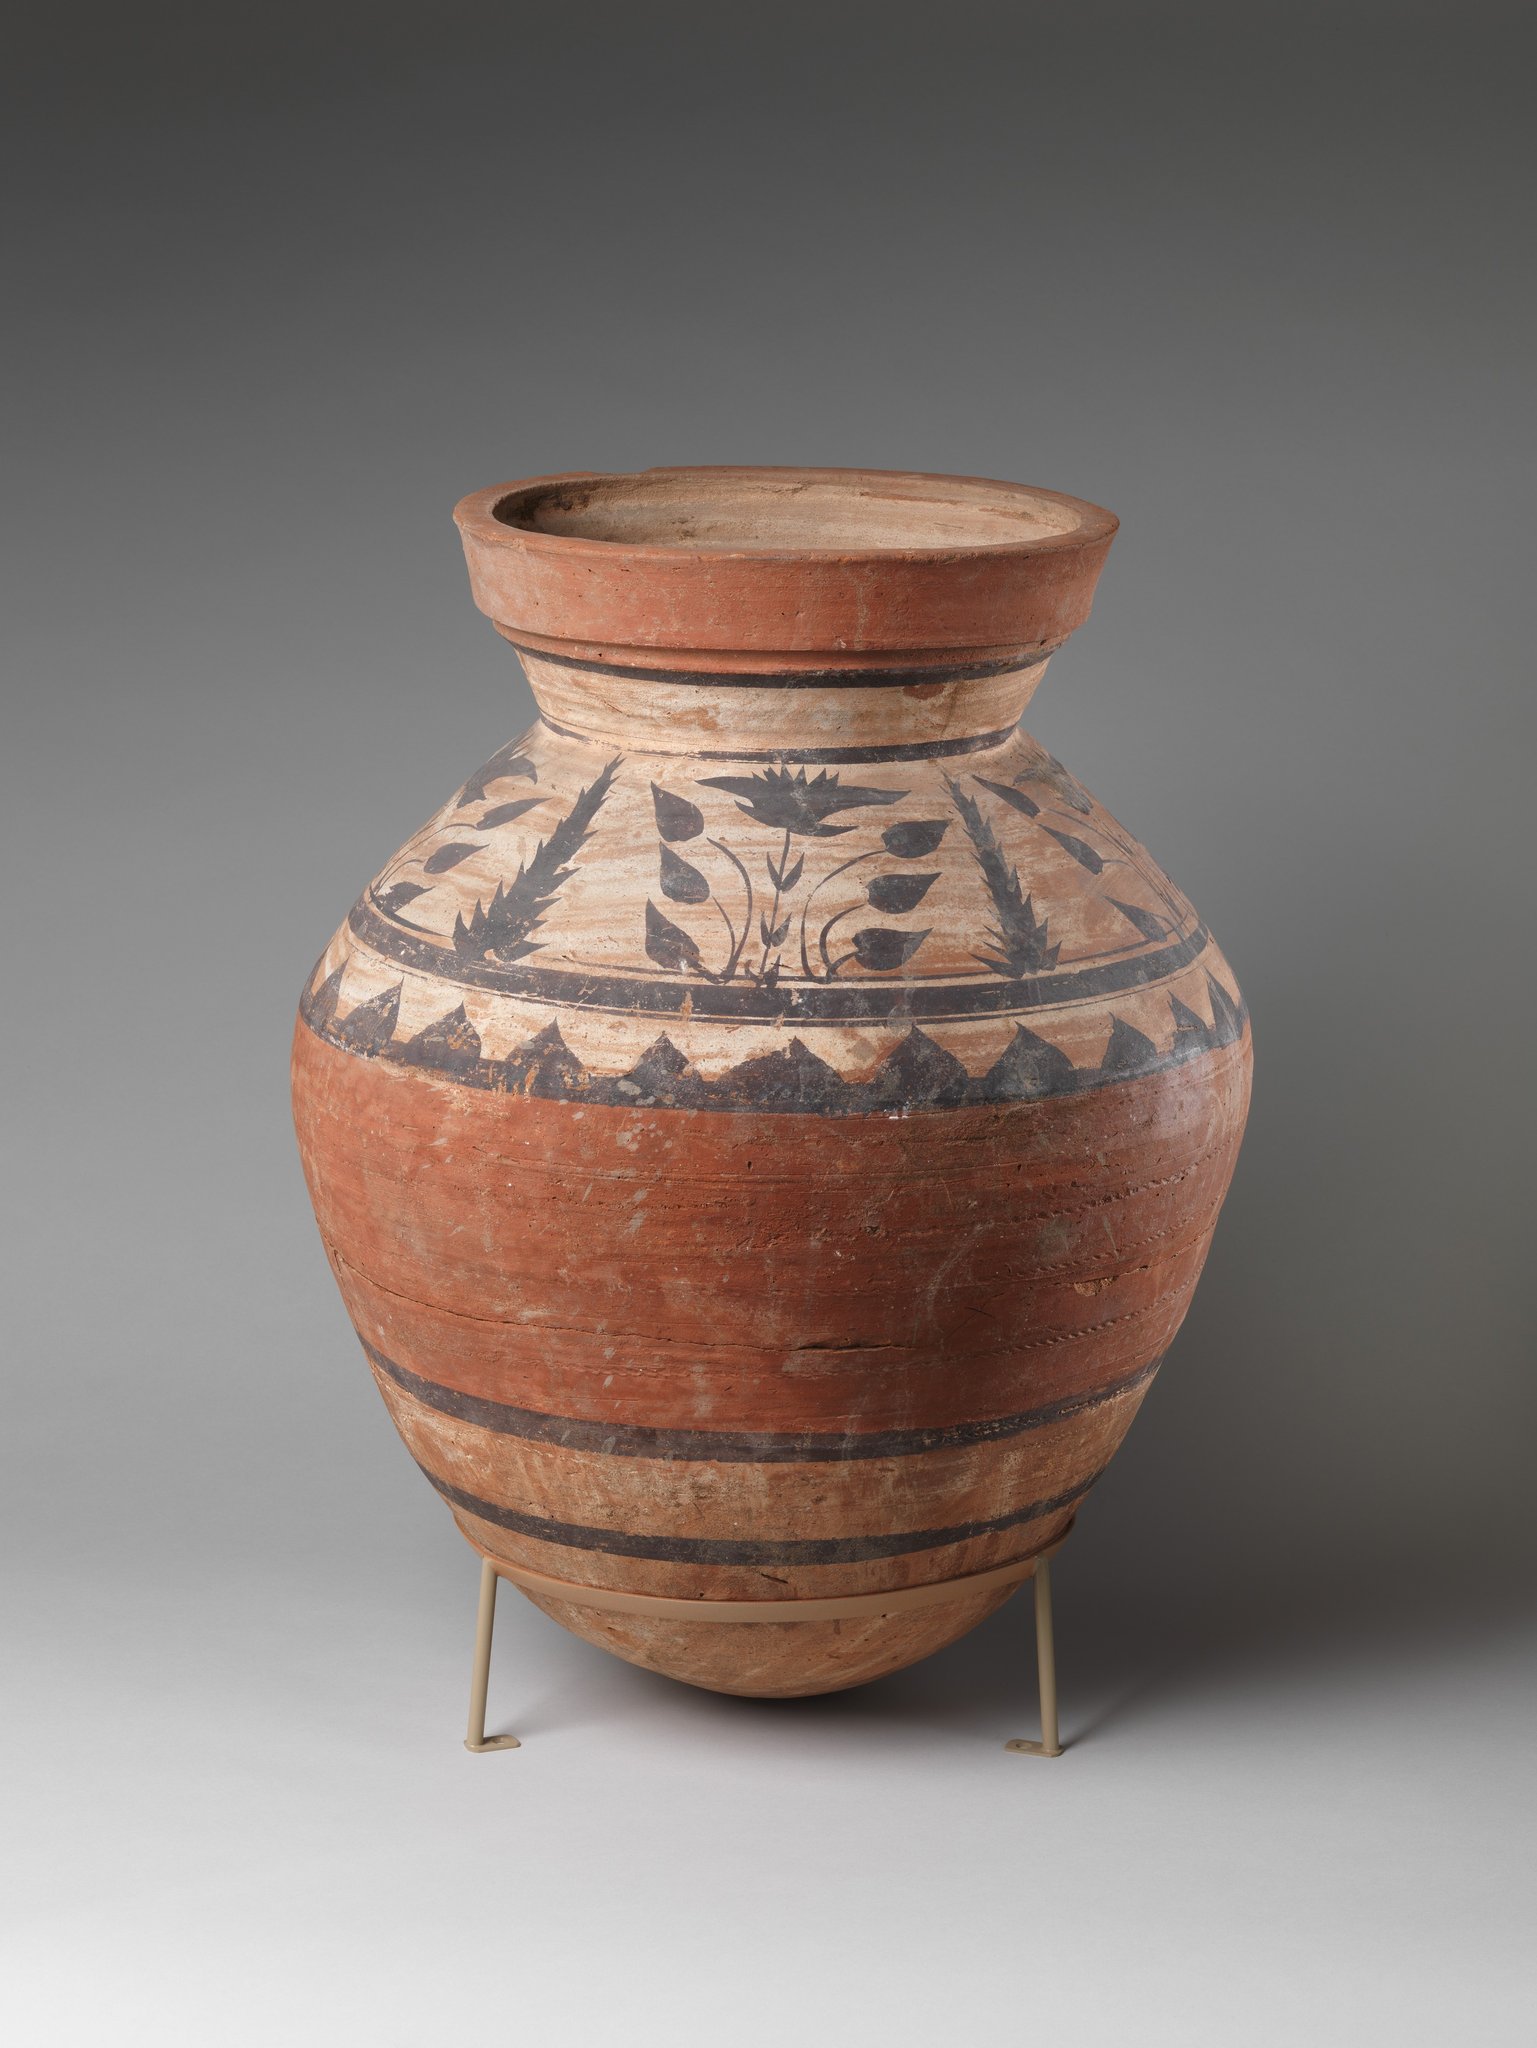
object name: jar, large storage, decorated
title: Large storage jar with floral decoration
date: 234-101 BCE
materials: paint, pottery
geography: egypt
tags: flowers